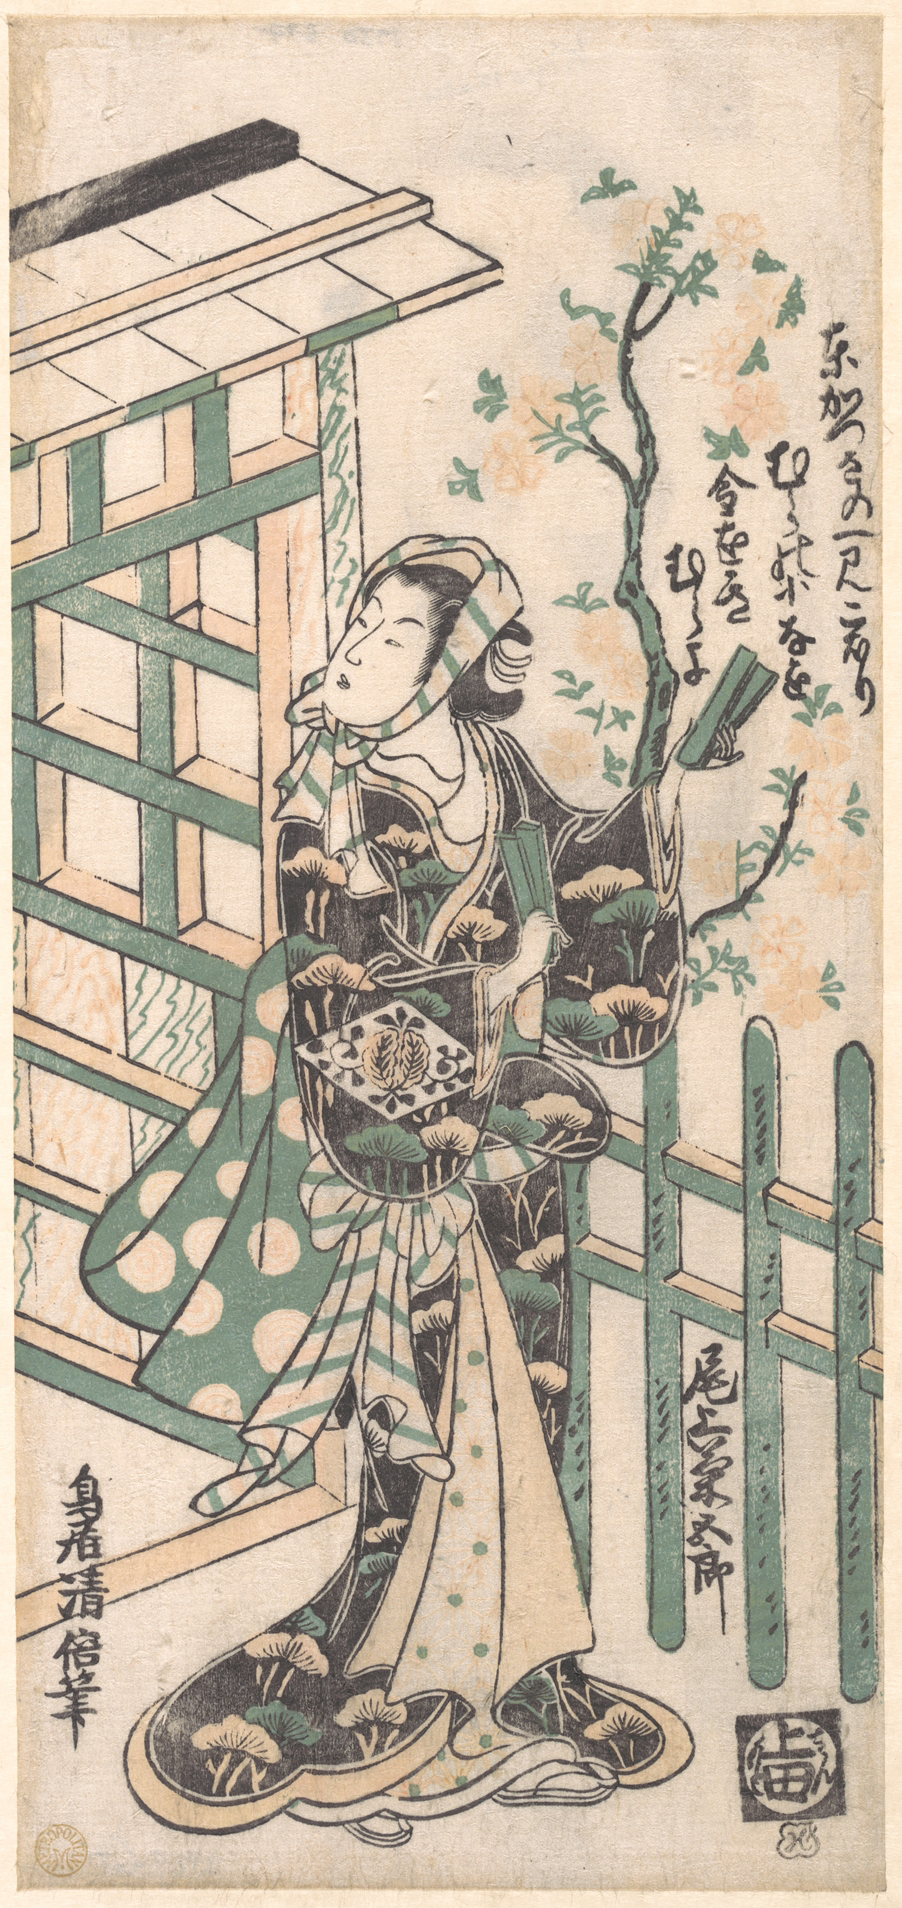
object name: print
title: The Actor Onoe Kikugoro as a Woman Standing by a Gate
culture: japanese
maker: torii kiyomasu i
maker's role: artist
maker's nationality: japanese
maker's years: 1696-1716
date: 1755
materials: ink, paper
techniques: woodblock print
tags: women,actors